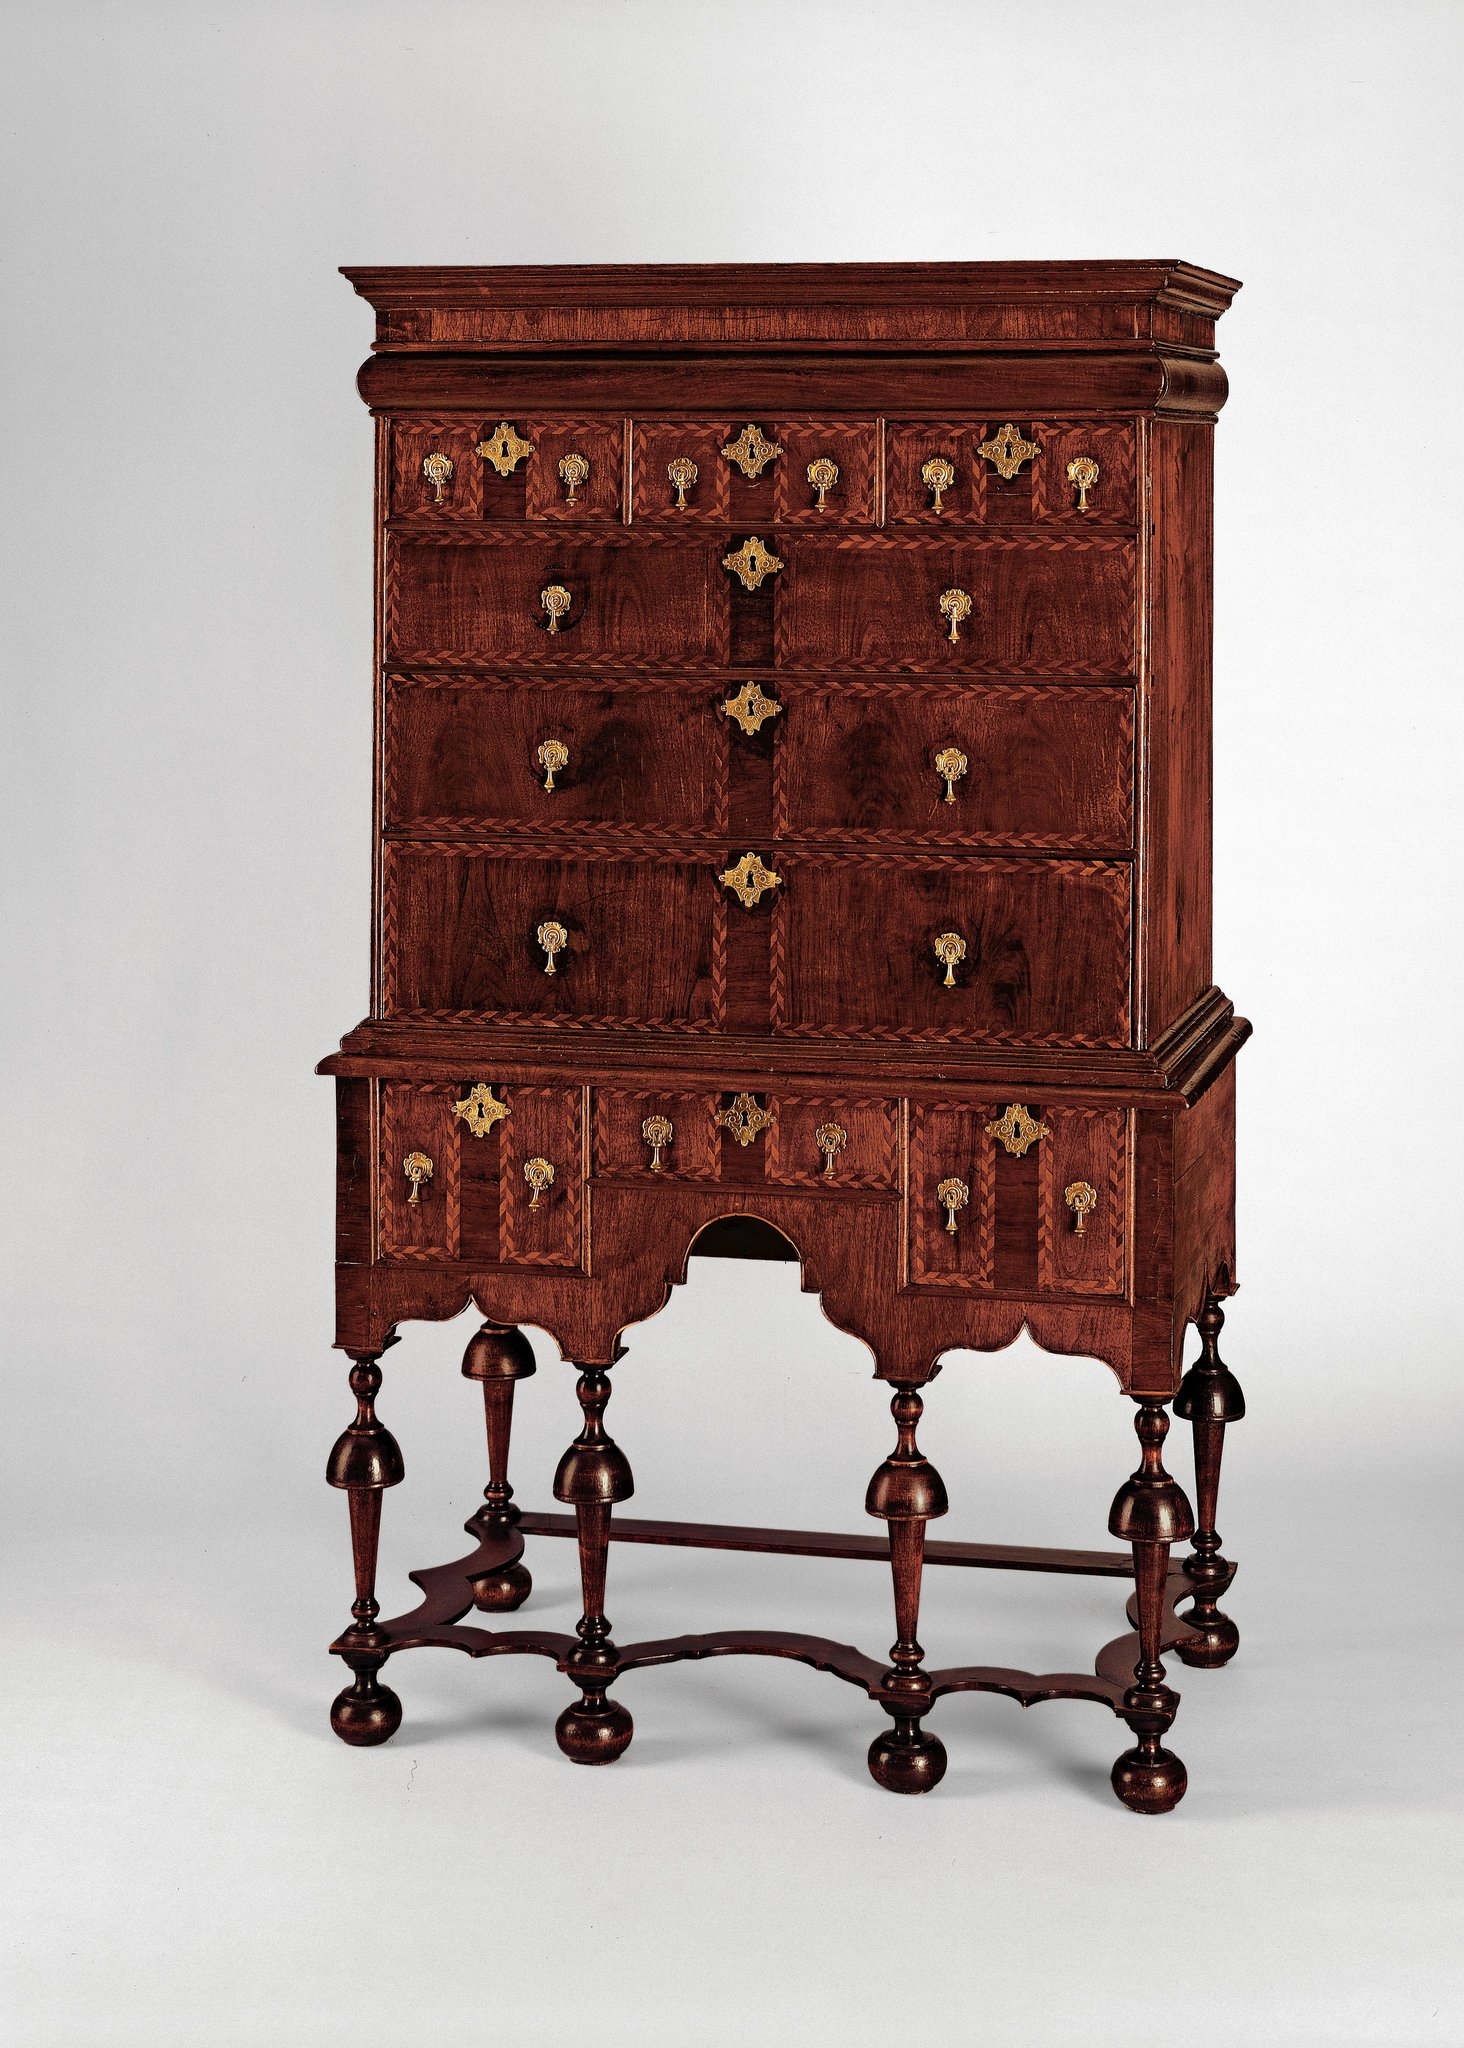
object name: chest of drawer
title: High chest of drawers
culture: american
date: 1715-1735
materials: wood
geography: united states